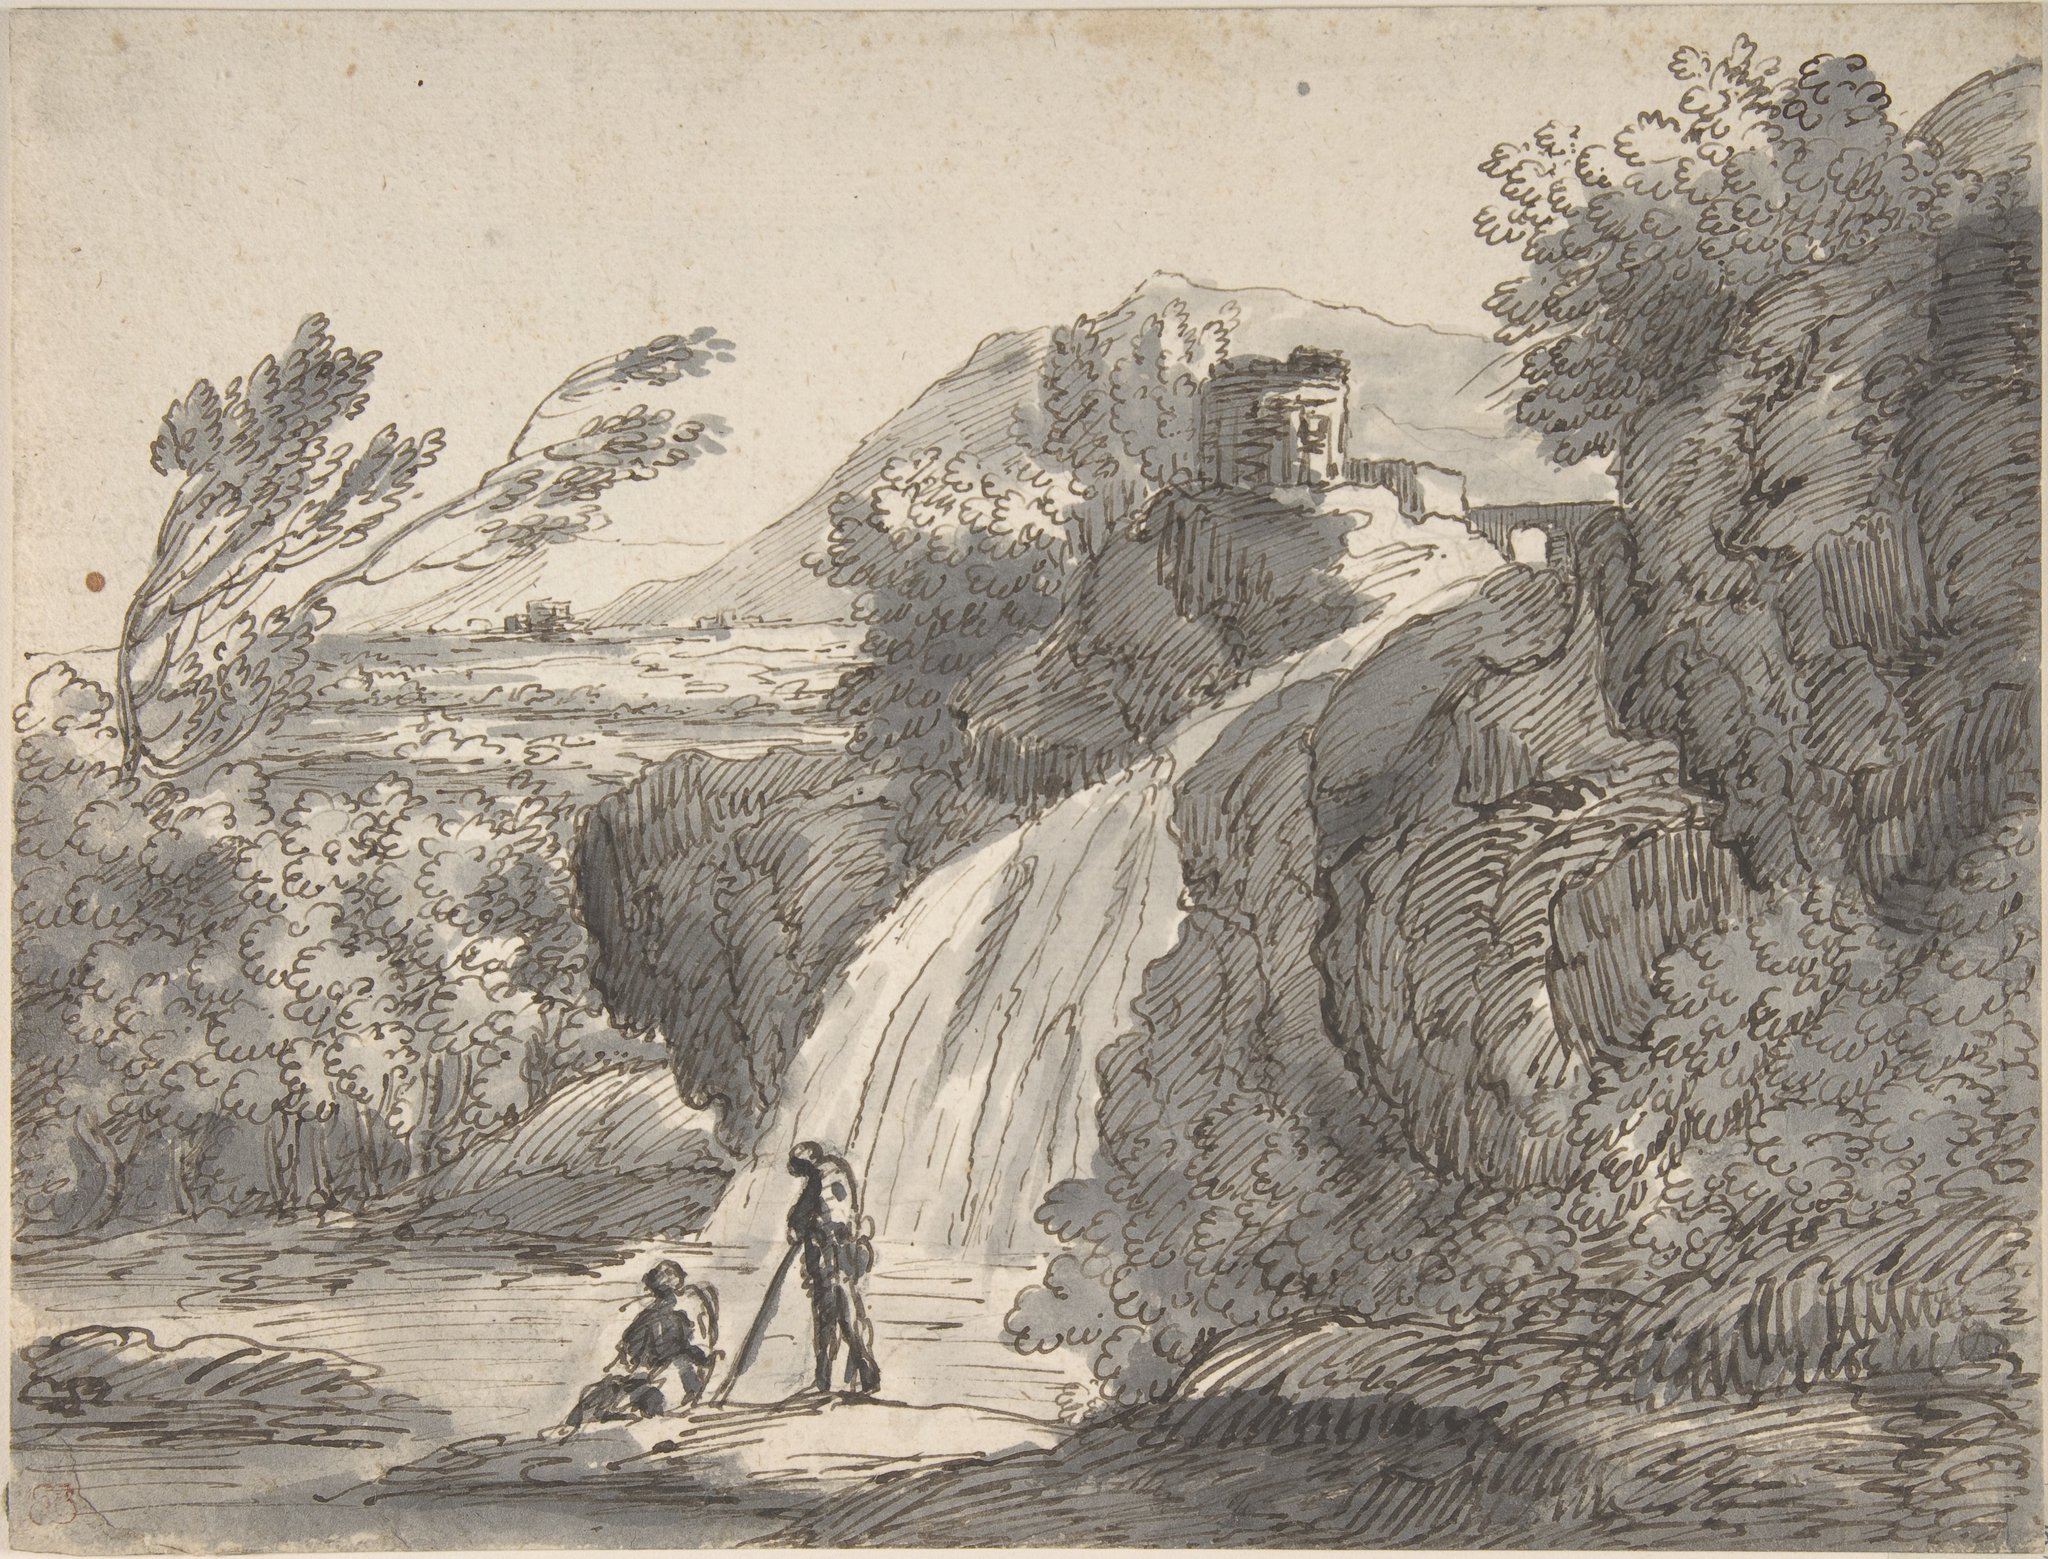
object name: drawing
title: Landscape with Two Figures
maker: anonymous, french, 17th century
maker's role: artist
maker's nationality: french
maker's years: 1600-1700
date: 1600-1699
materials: ink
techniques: brush, pen, wash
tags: human figures,landscapes,trees